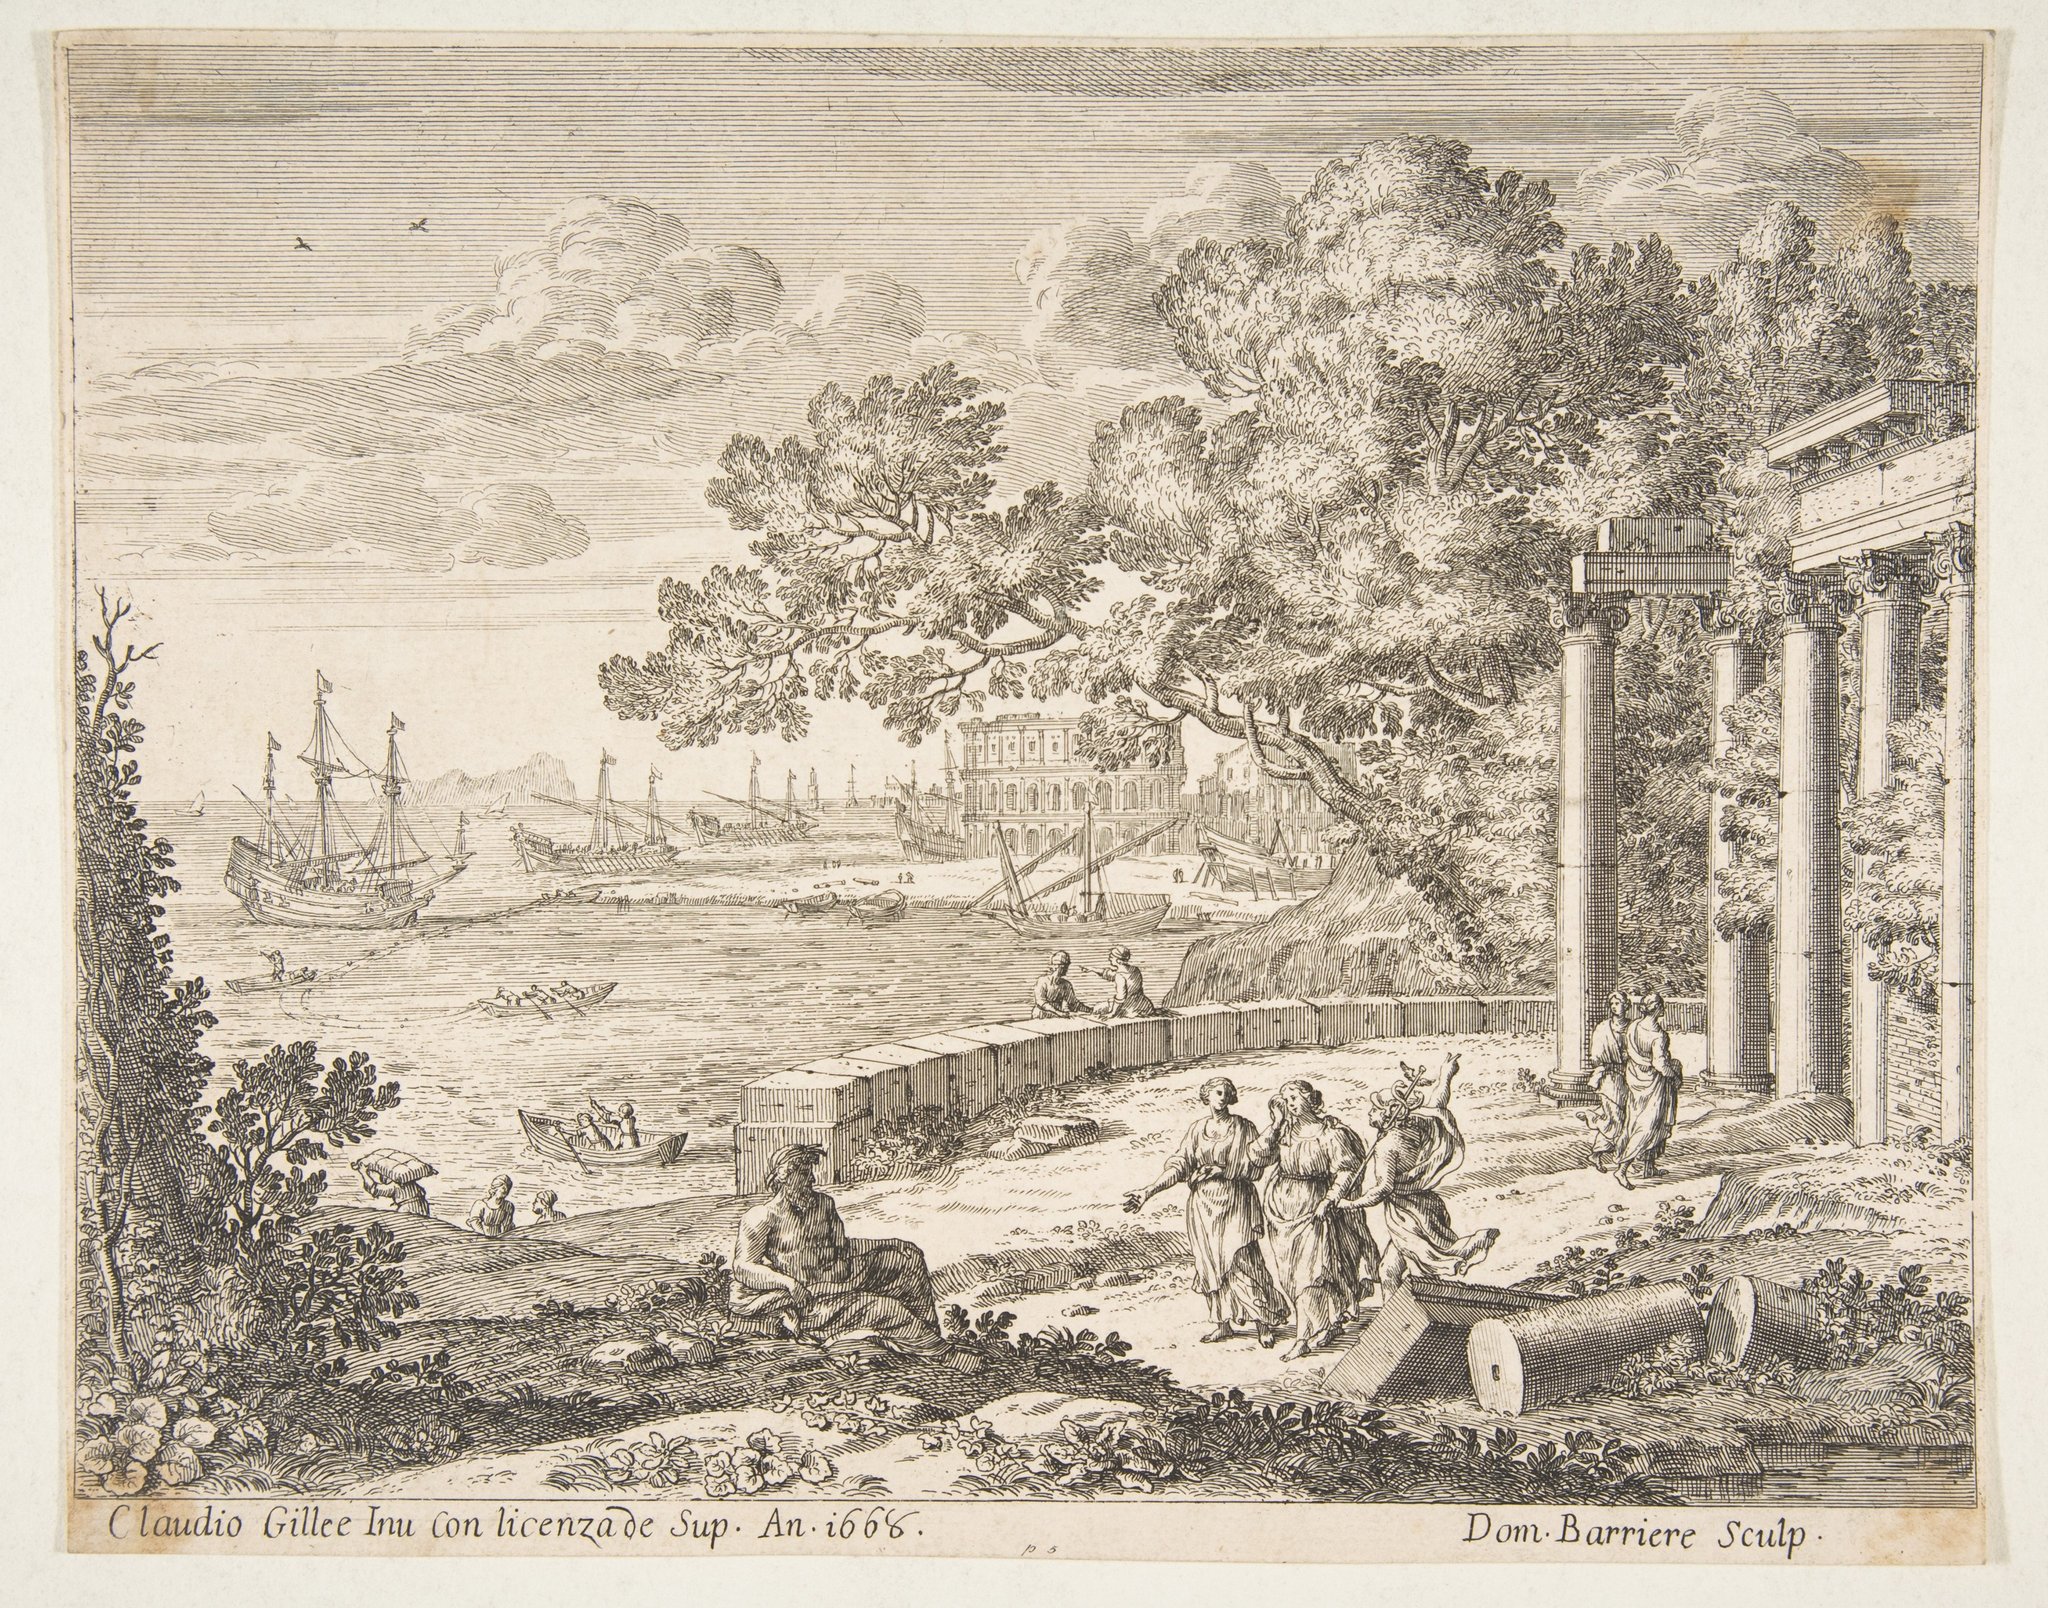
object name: print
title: Landscape with Mercury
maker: claude lorrain (claude gellée)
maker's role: artist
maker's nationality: french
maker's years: 1604-1682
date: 1668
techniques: etching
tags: ruins,mercury,landscapes,ships